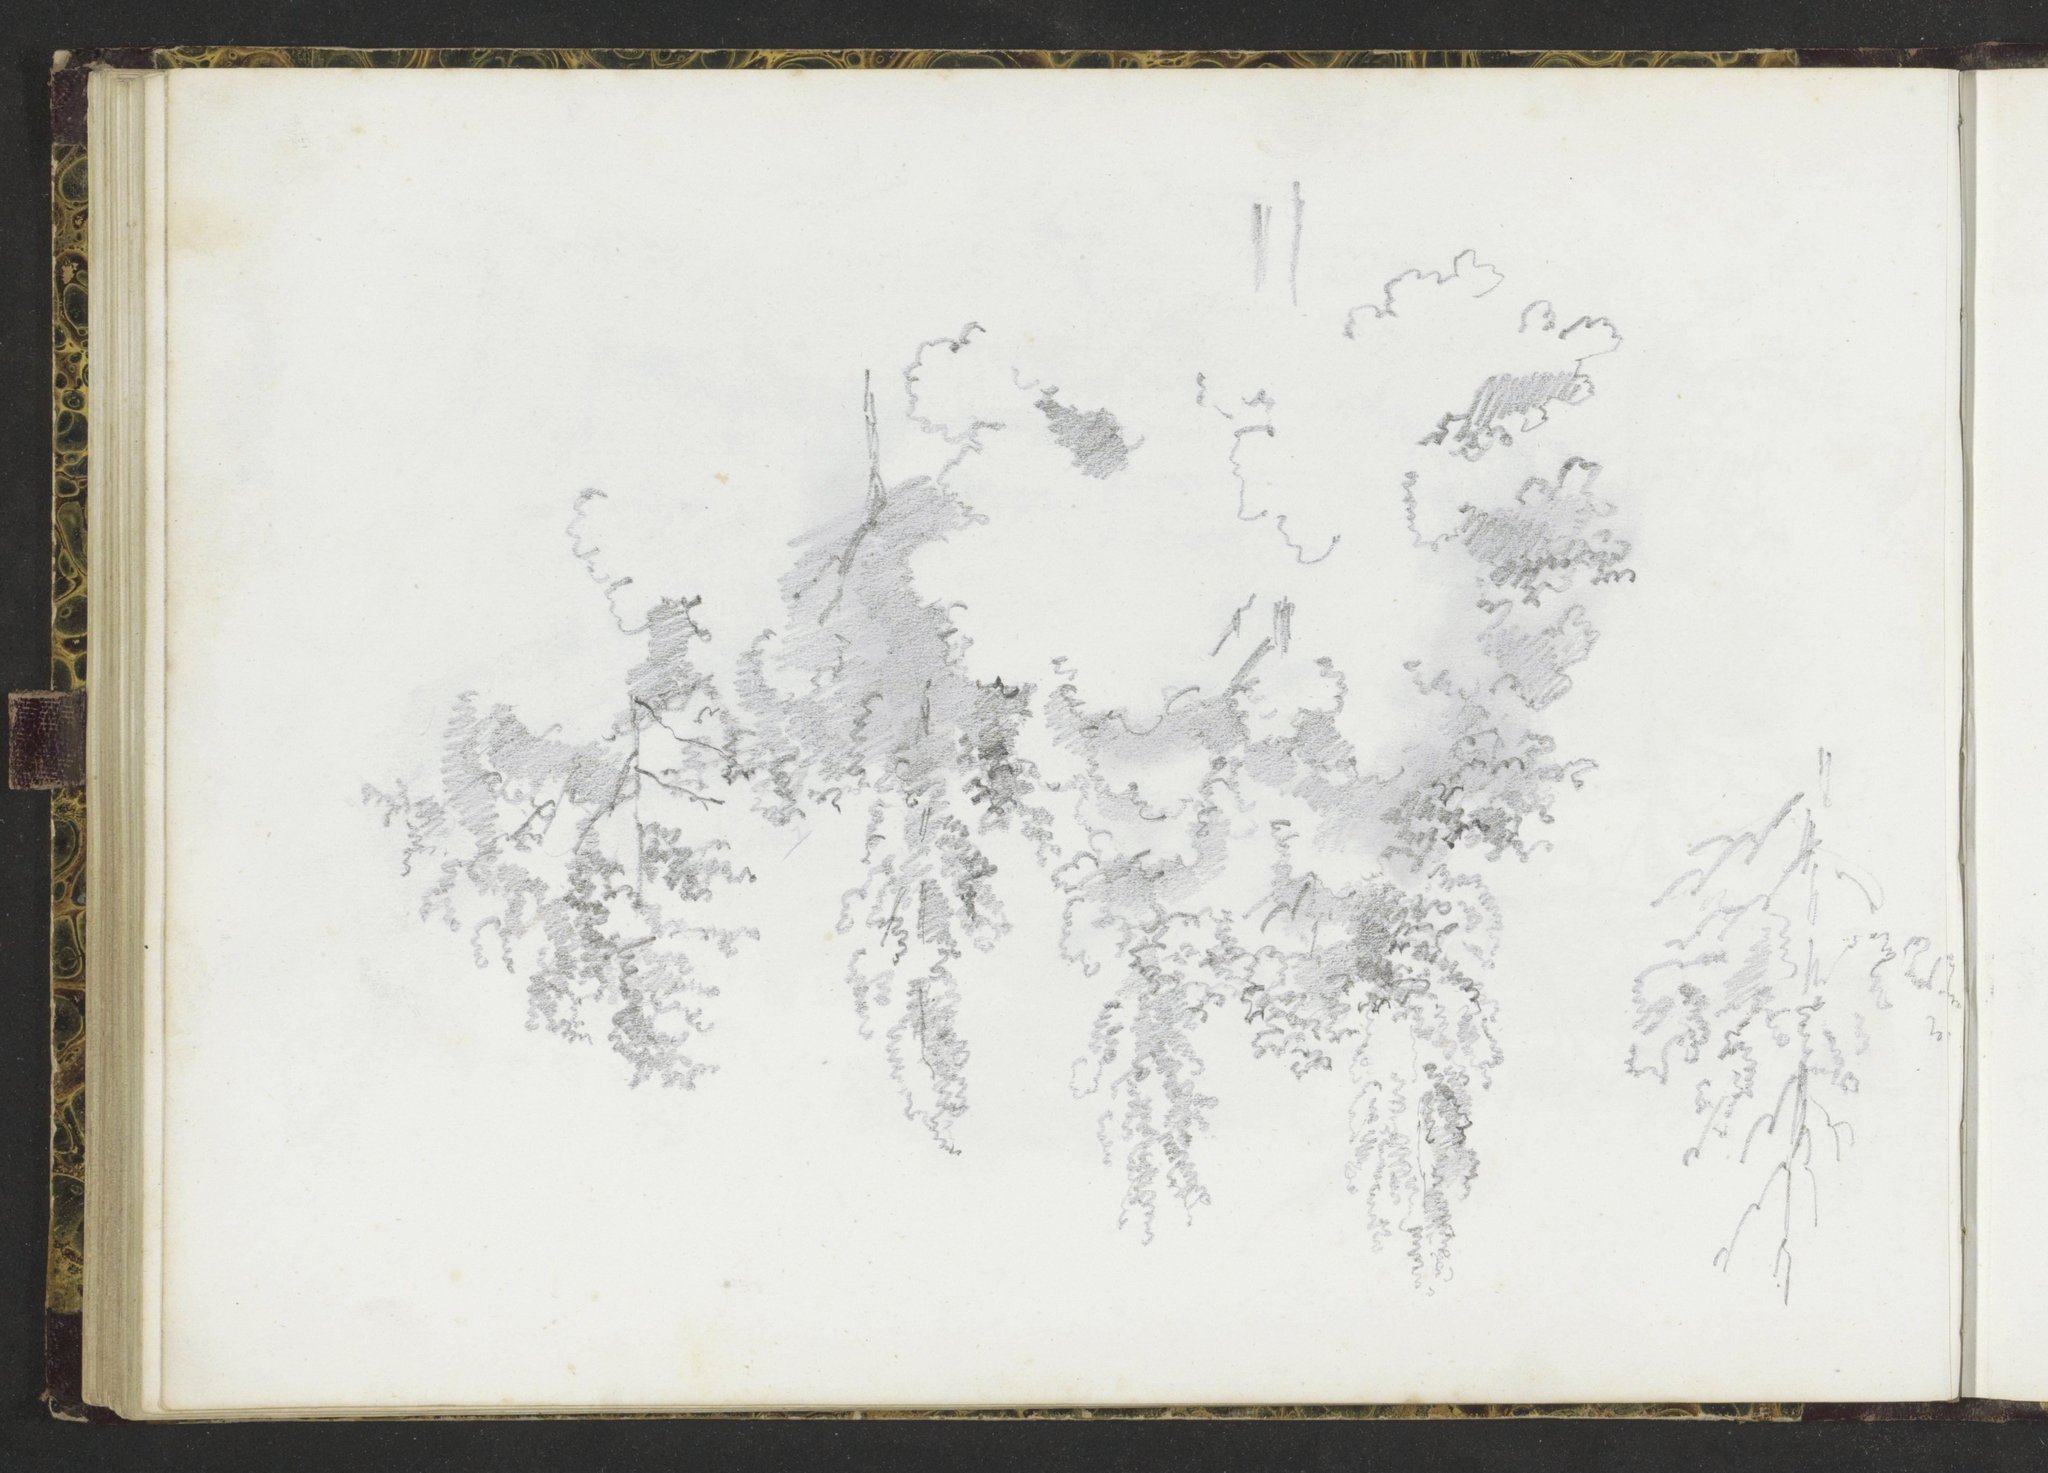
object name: sketchbook leaf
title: Bomen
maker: lambertus lingeman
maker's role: draughtsman, painter, print maker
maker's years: 1829-1894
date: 1839-1894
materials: paper, pencil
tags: trees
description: Blad 45 verso uit een schetsboek met 51 bladen.